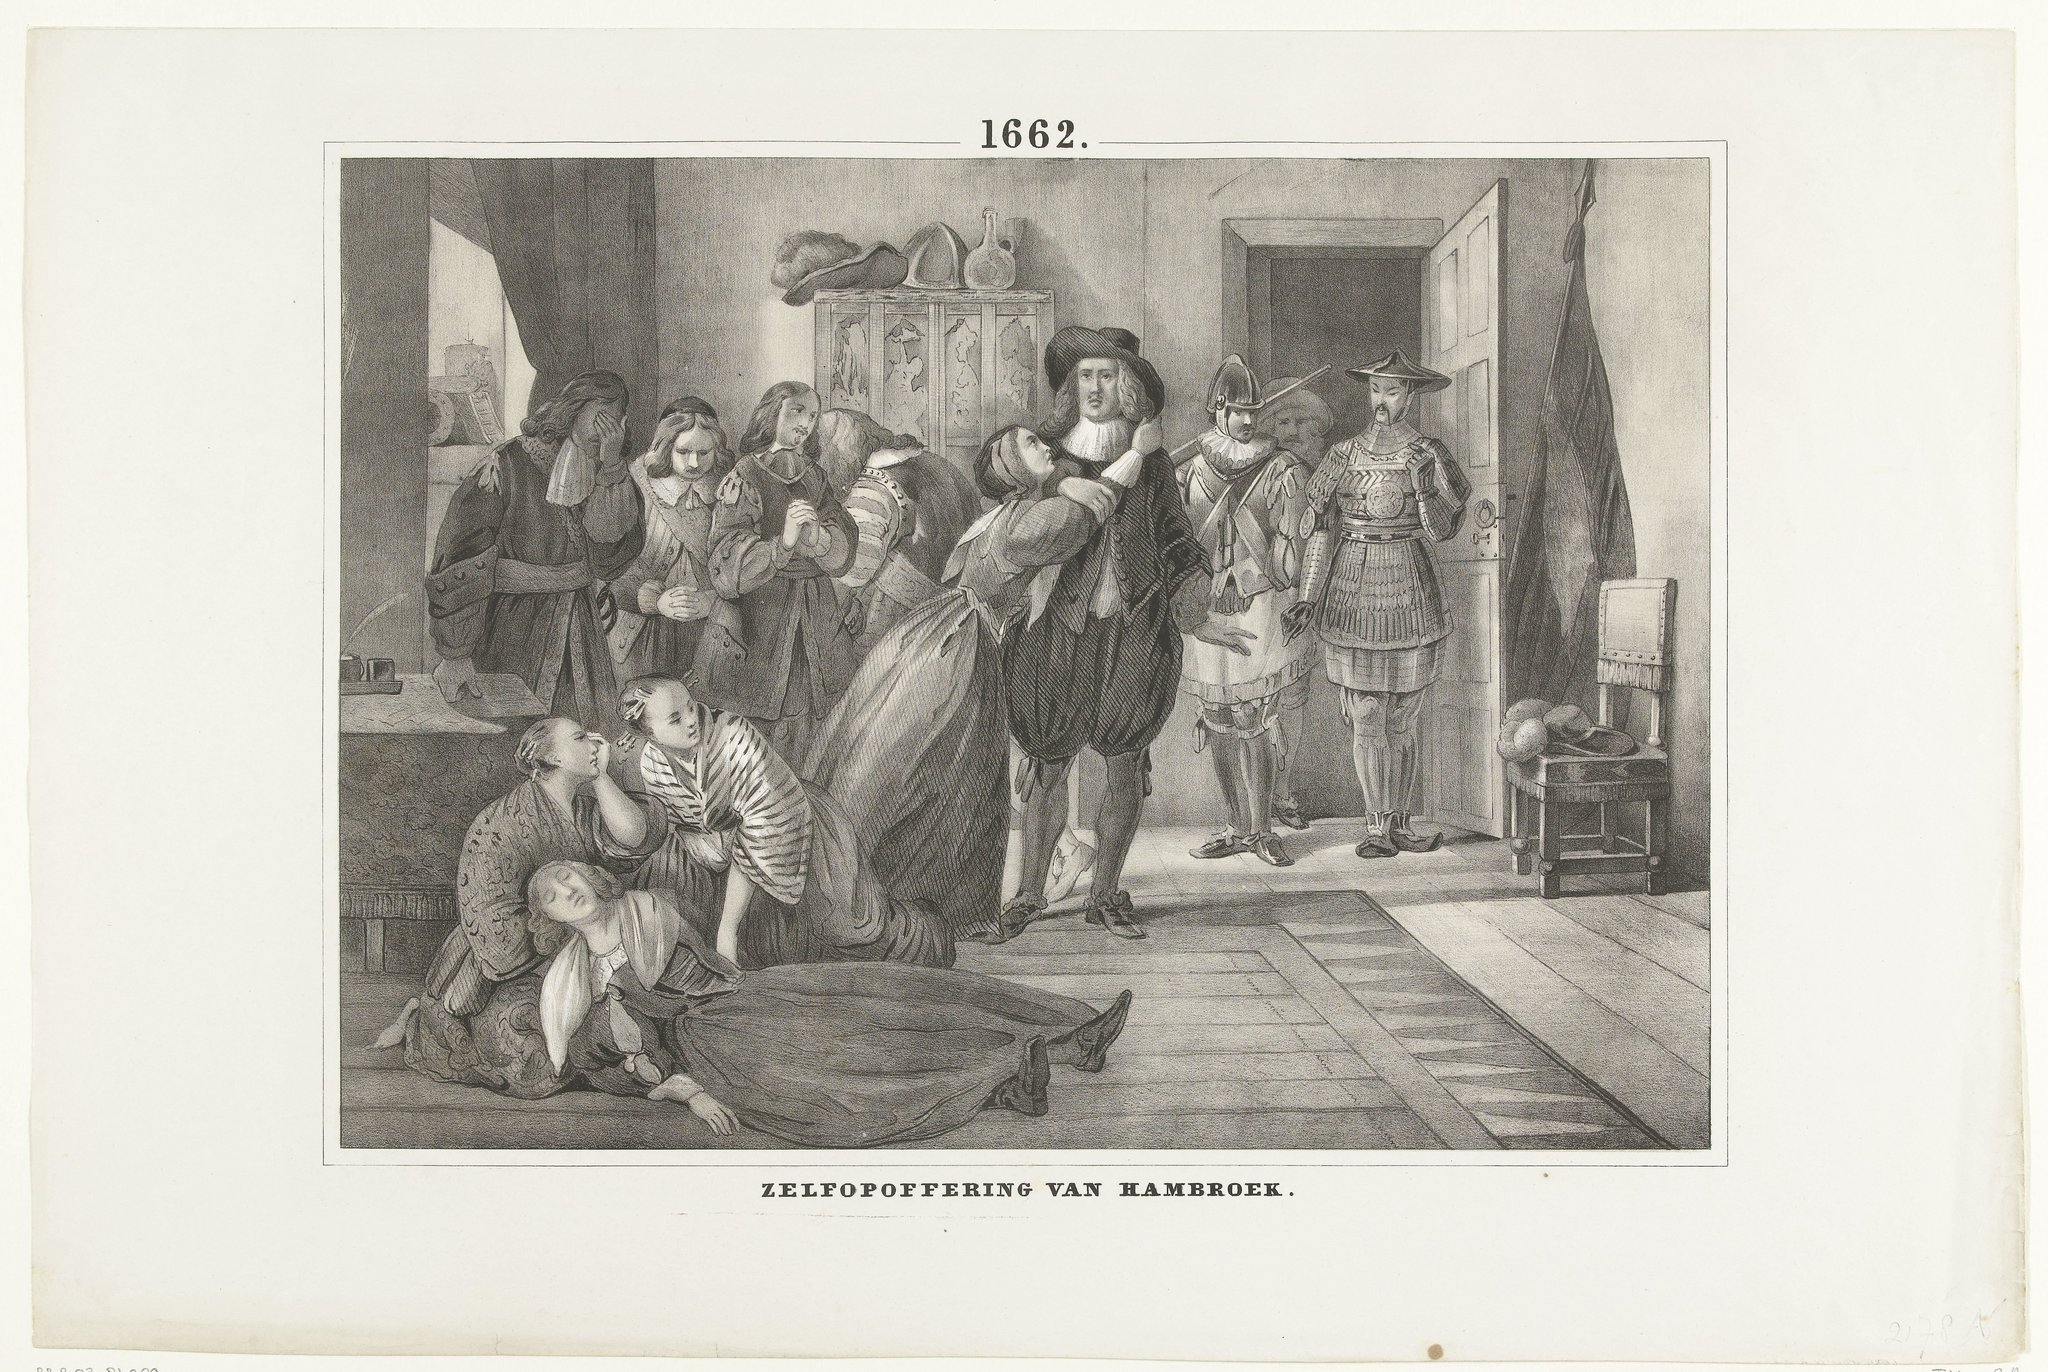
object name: print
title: 1662 / Zelfopoffering van Hambroek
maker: Anonymous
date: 1853-1855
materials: paper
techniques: lithograph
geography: netherlands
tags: rotterdam, formosa, asking someone not to leave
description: De zelfopoffering van predikant Hambroeck op Formosa. Na het verzoek om overgave van de Chinezen persoonlijk te hebben overgebracht aan de Hollandse bevelhebbers van Fort Zeelandia op Formosa, neemt Hambroeck afscheid van zijn dochters en keert terug naar de Chinese zeerover Coxinga, 24 mei 1661. In oktober 1661 wordt hij door de Chinezen vermoord.